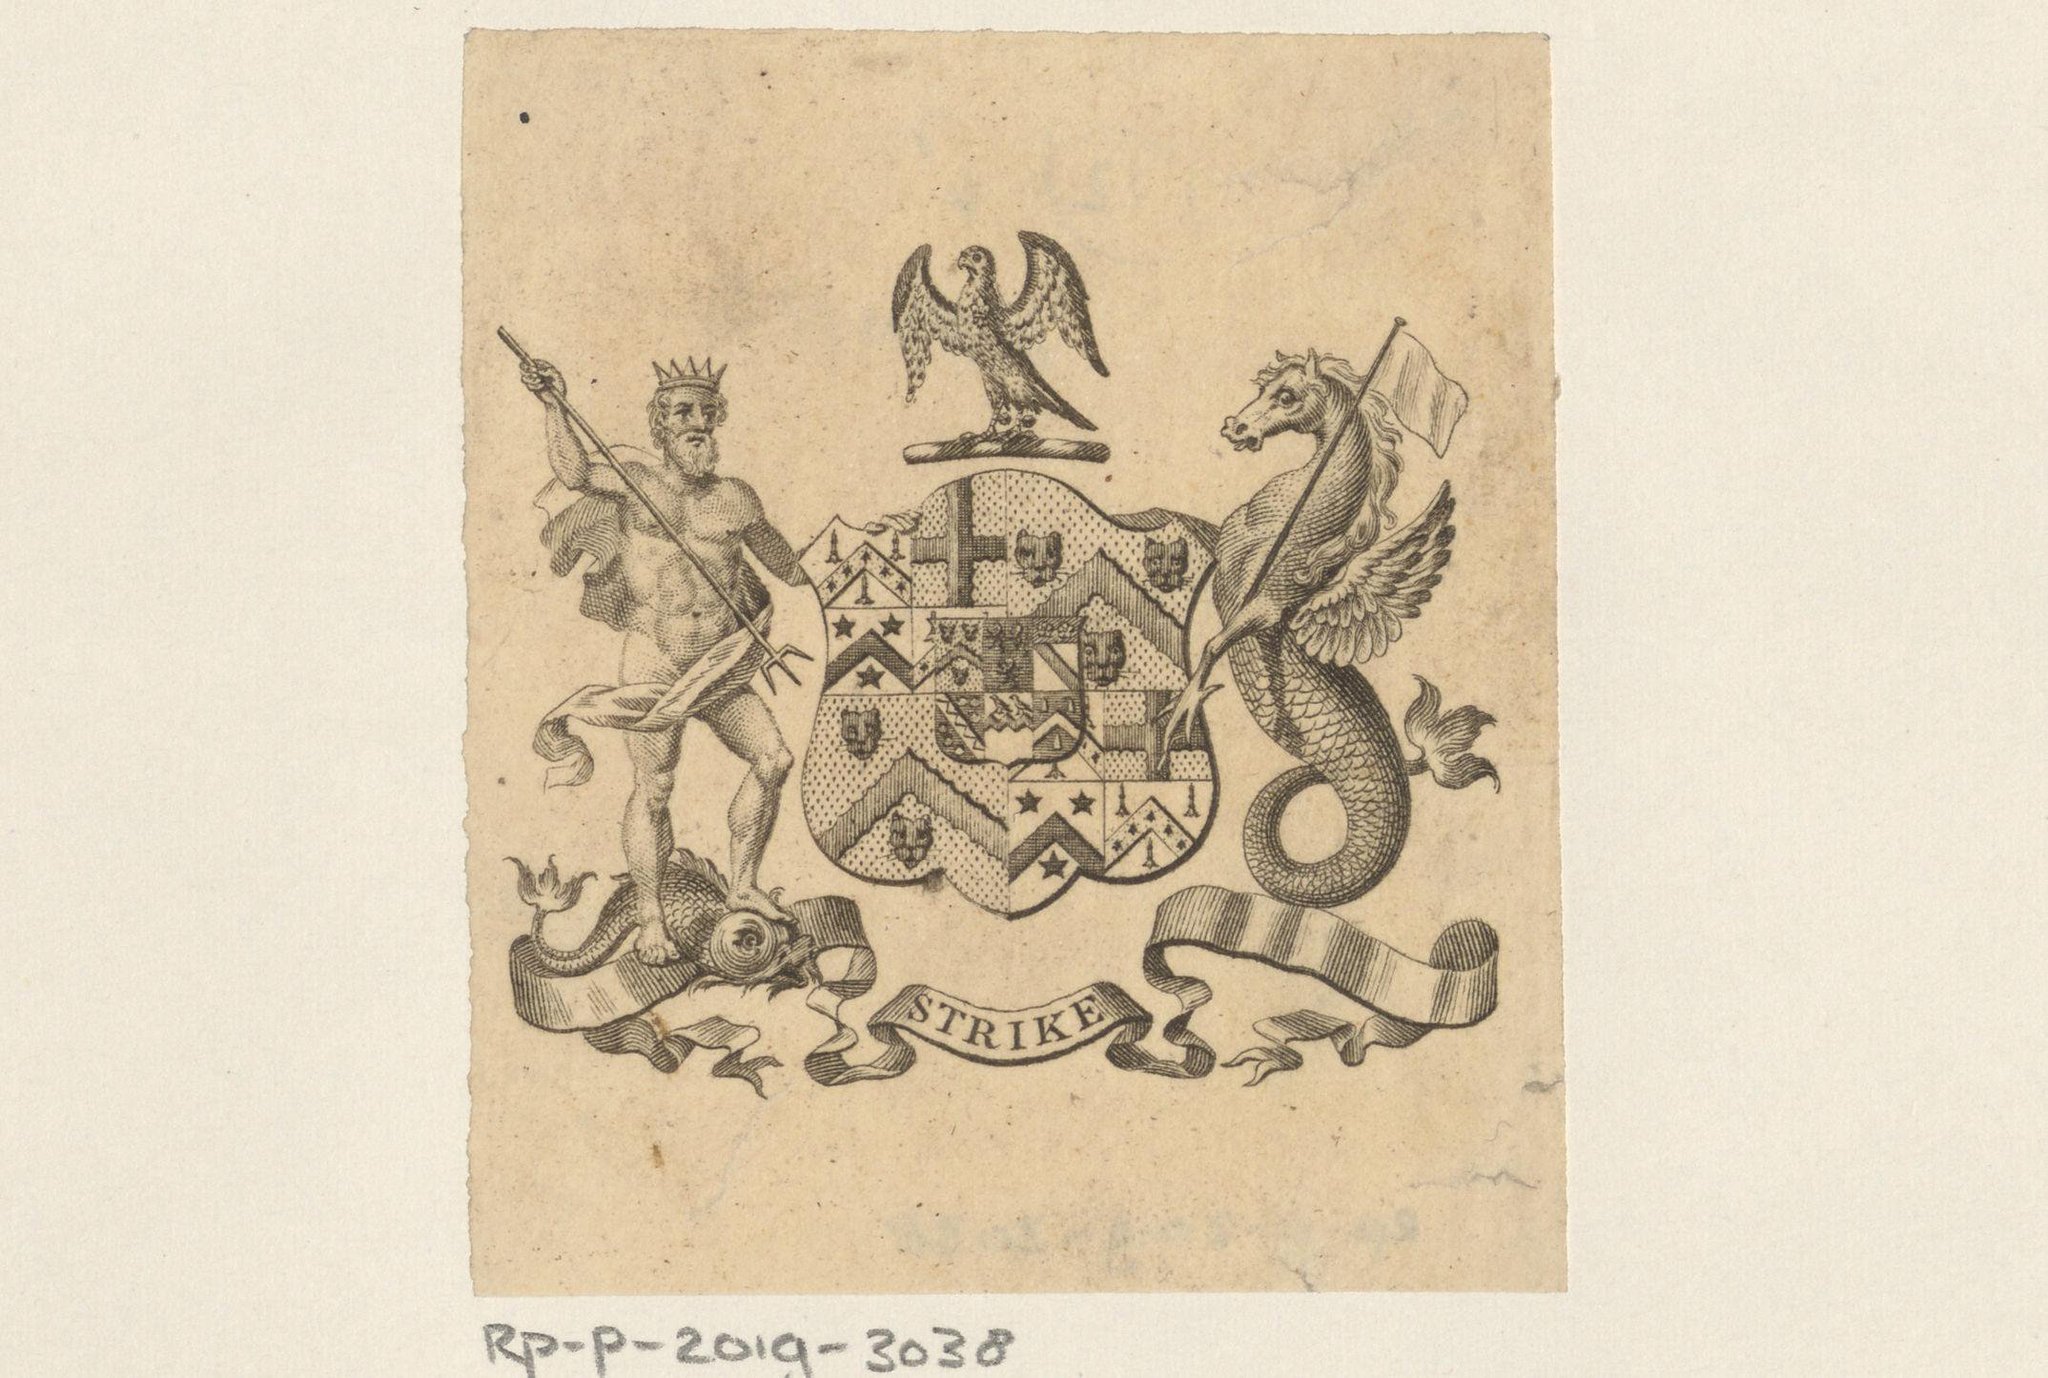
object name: bookplate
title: Strike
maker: Anonymous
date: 1700-1849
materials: paper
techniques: engraving, etching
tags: armorial bearing, heraldry